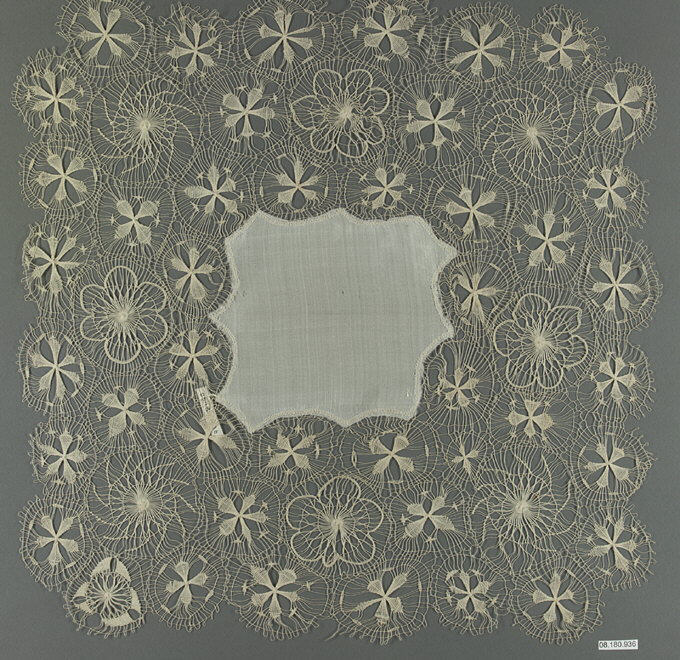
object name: handkerchief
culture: paraguayan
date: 1801-1900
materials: silk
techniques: embroidery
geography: paraguay